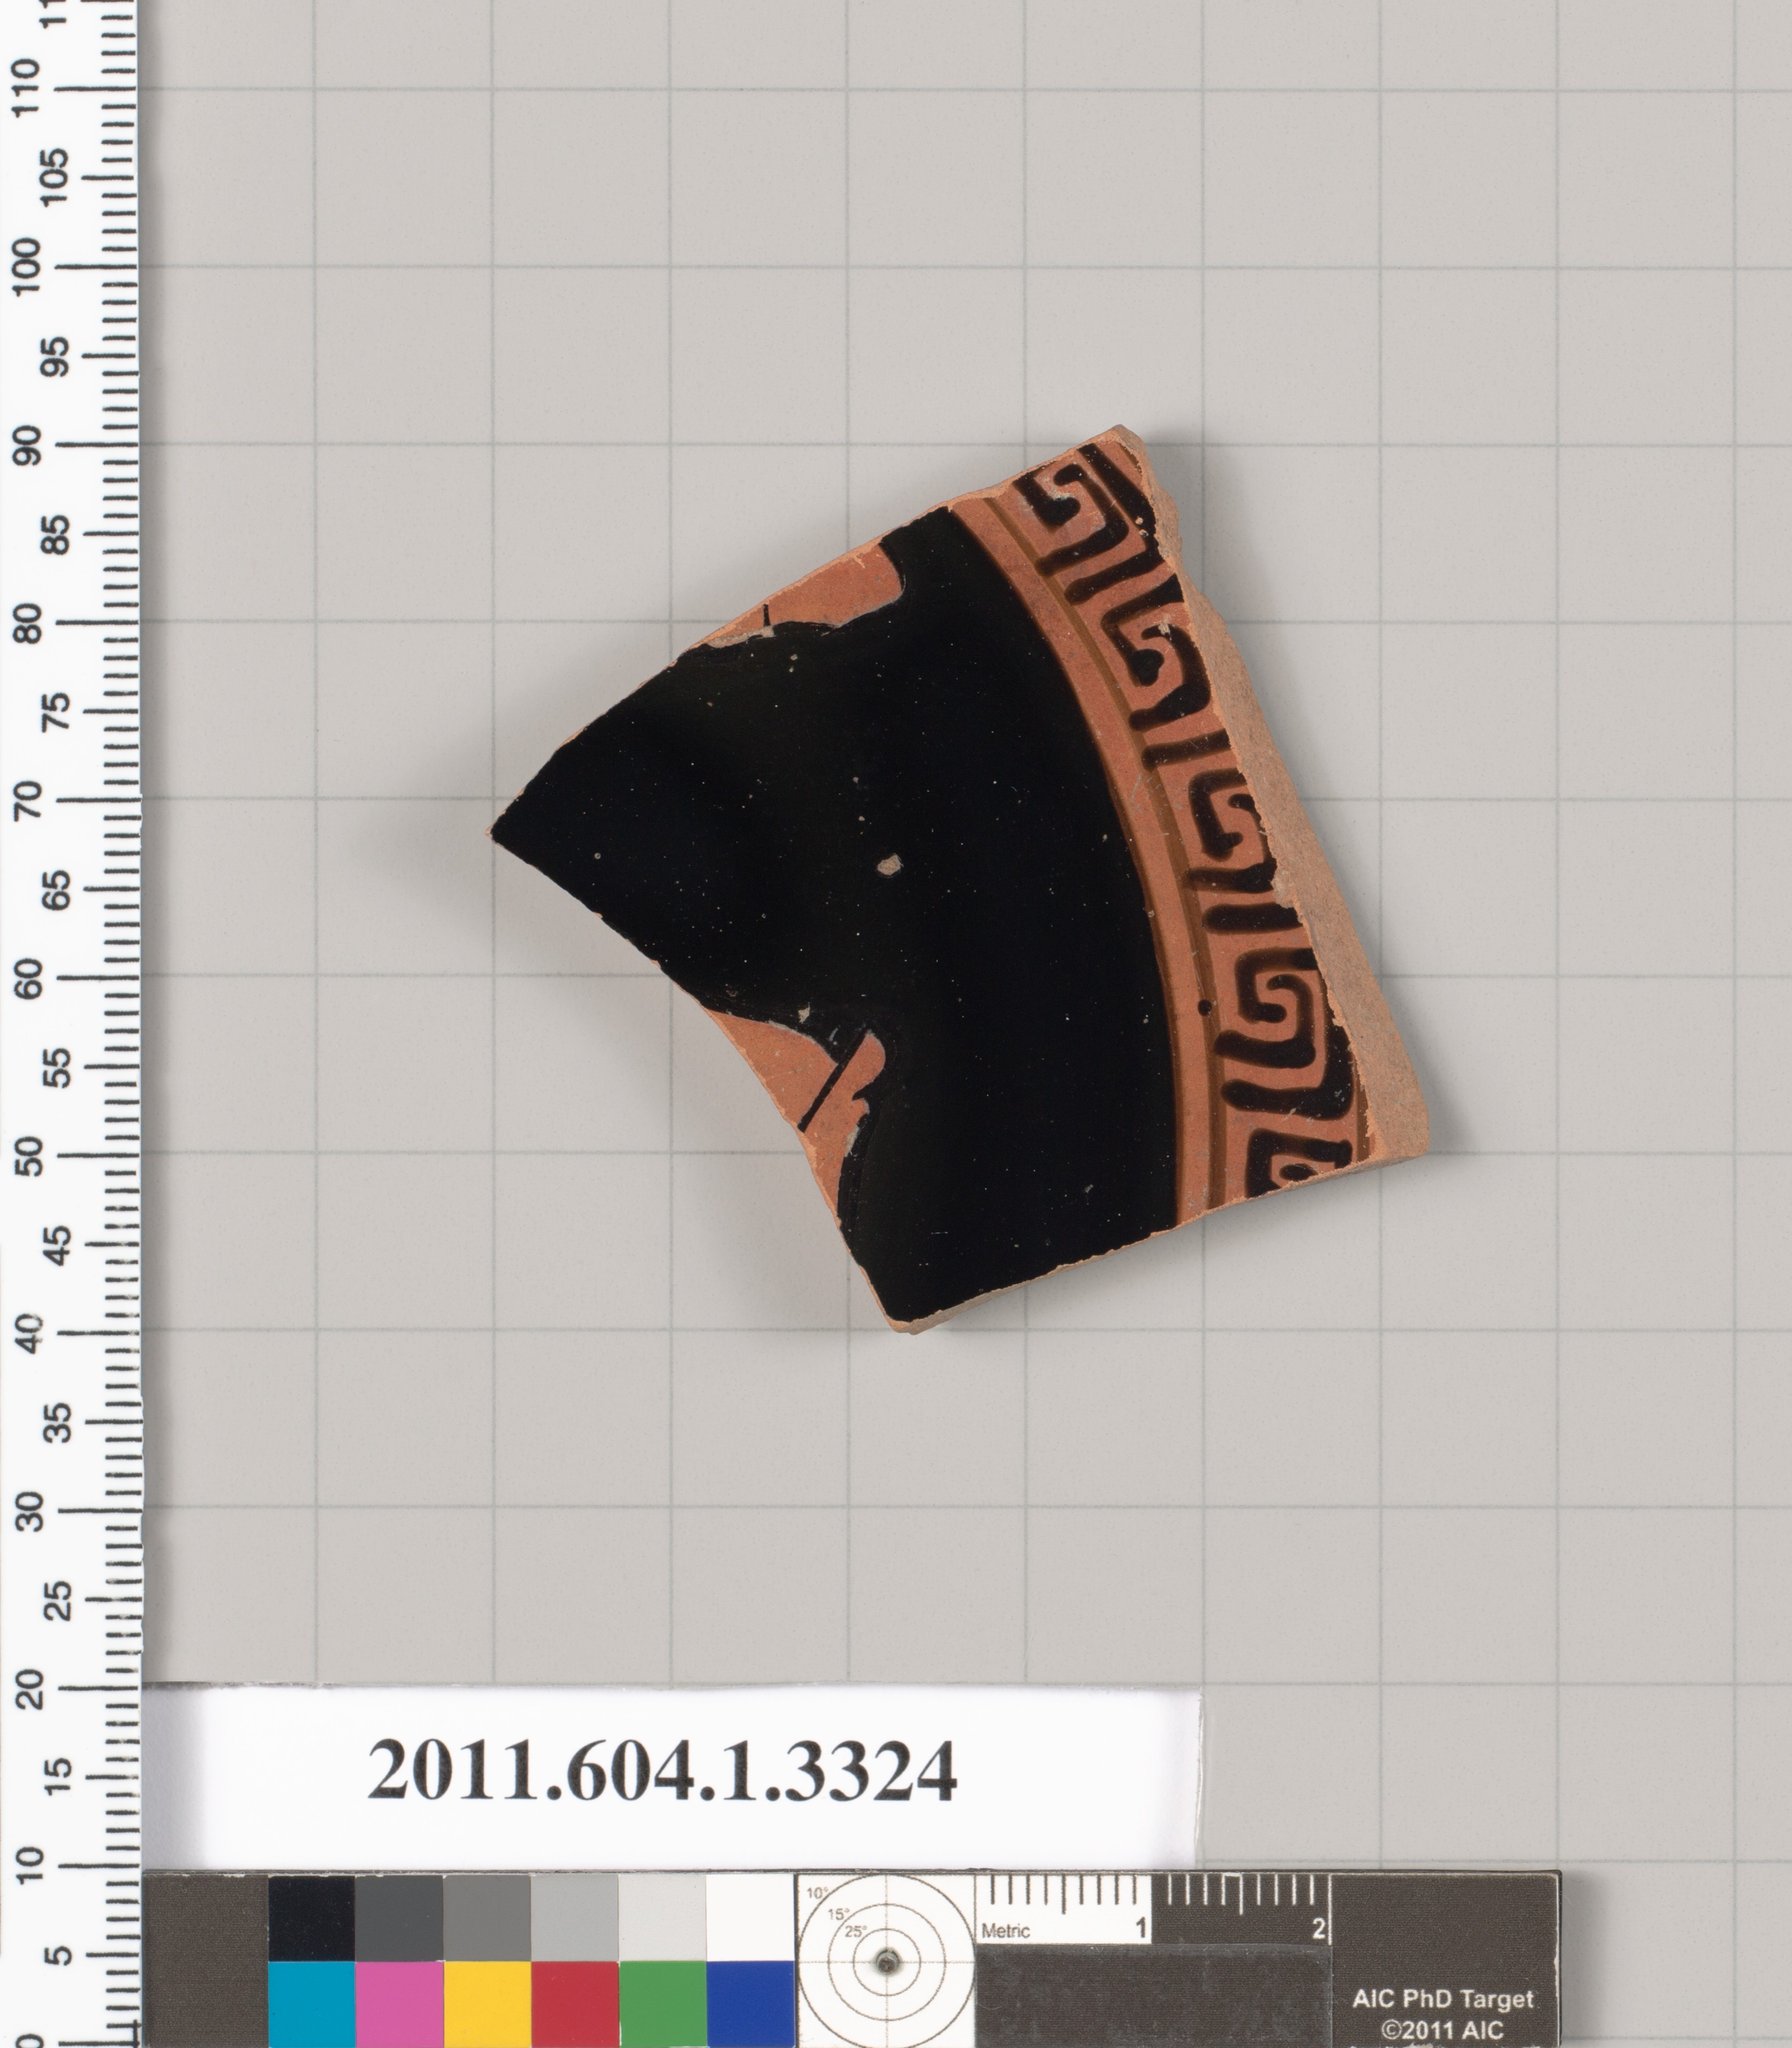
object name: kylix fragment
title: Terracotta fragment of a kylix (drinking cup)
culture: greek, attic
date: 500-476 BCE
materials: terracotta